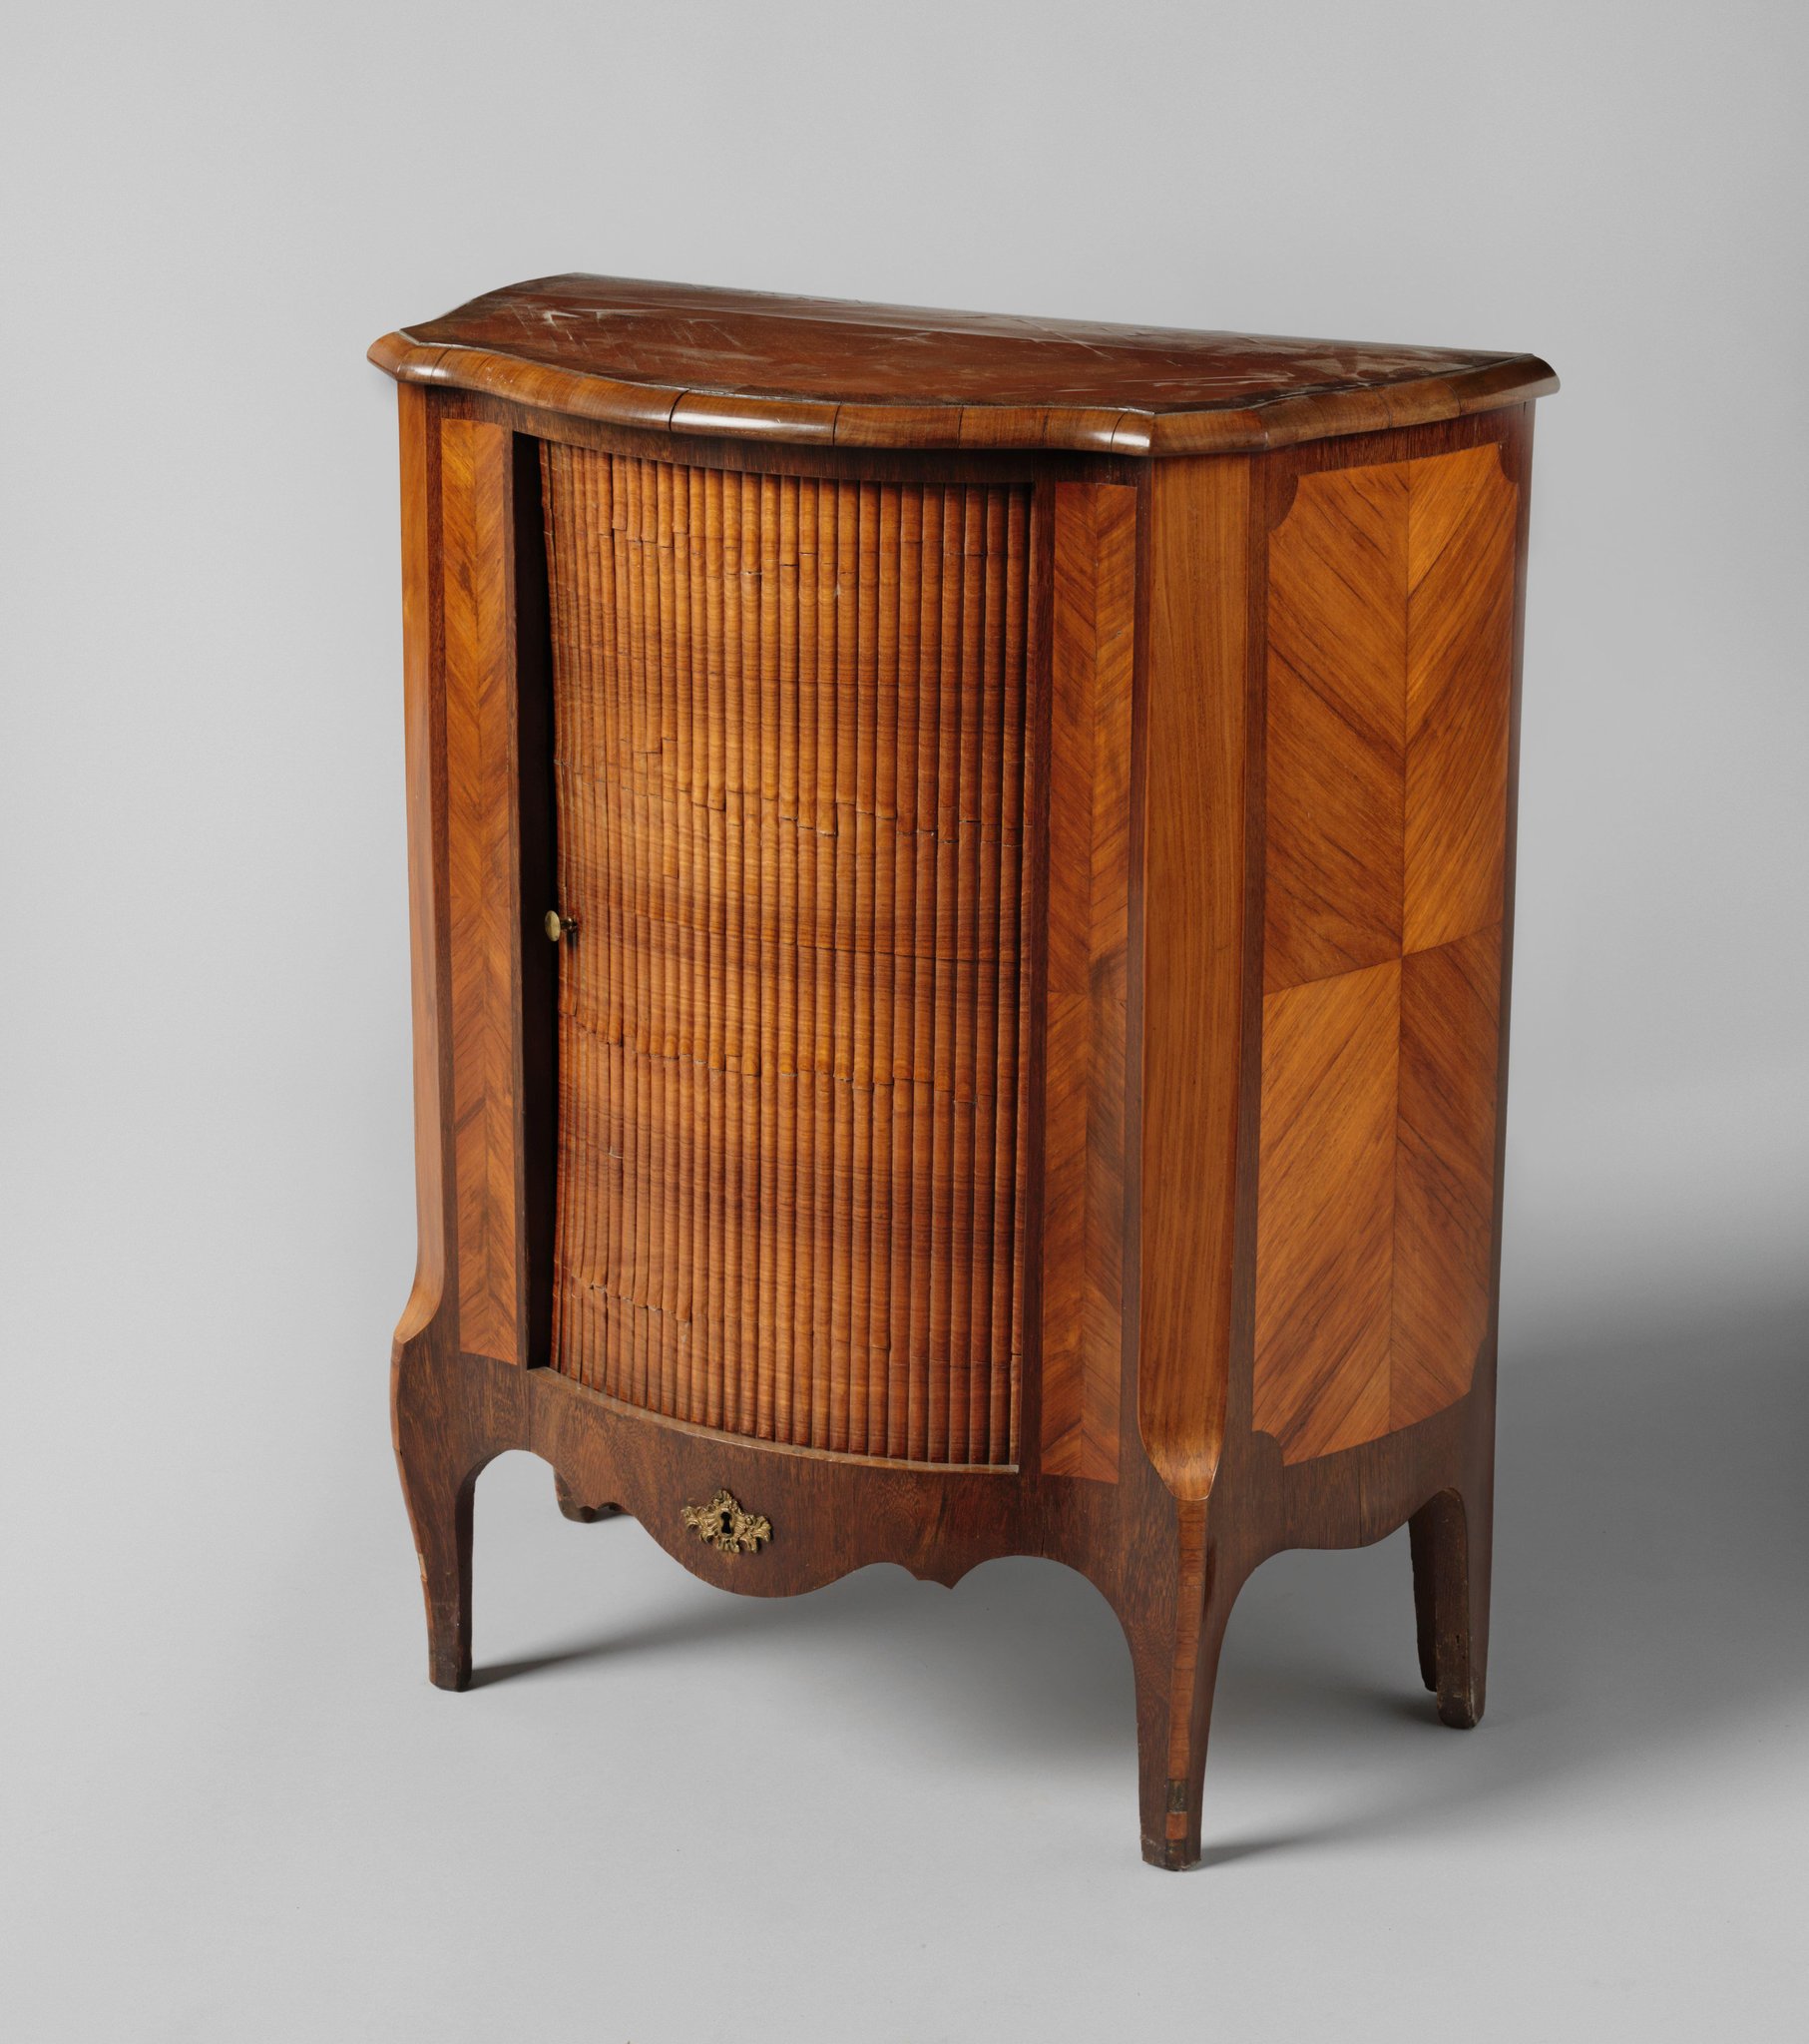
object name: case furniture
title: Kast met jalouziedeur en stijlen versierd met visgraatpatroon.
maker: Anonymous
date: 1770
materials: brass, wood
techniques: marquetry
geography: northern netherlands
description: Kast belijmd met roze- en palissanderhout. De gebolde jaloeziedeur draagt op de geschulpte onderregel beslag rond een sleutelgat en wordt geflankeerd door stijlen versierd met marqueterie in een visgraatpatroon. De overhoeks geplaatste hoekstijlen lopen over in de S-vormige voorpoten.